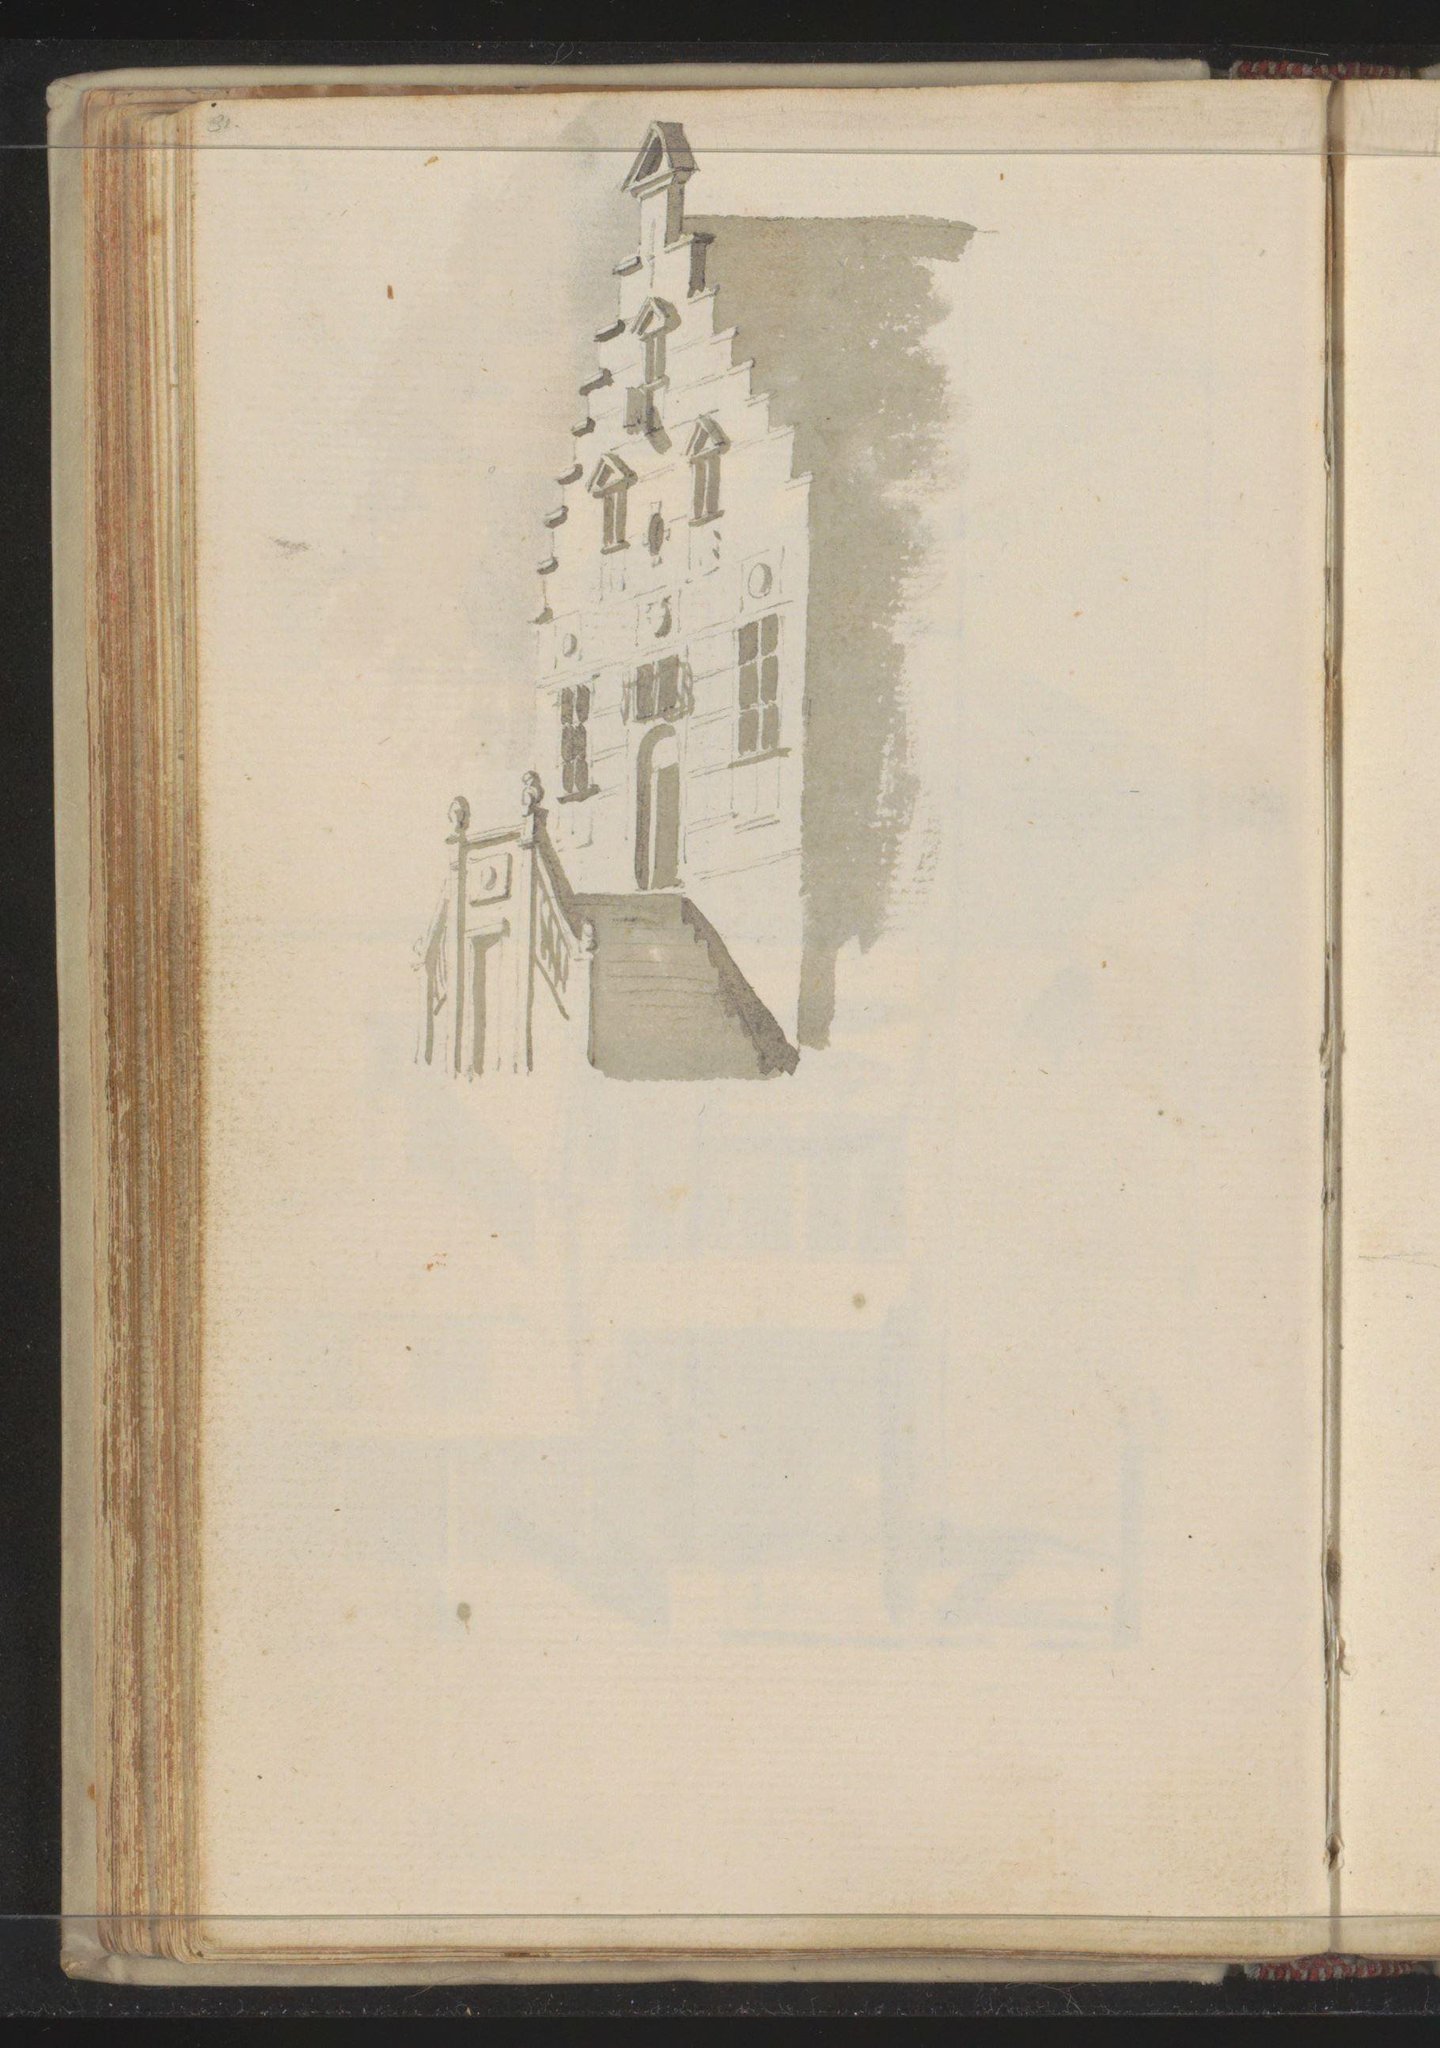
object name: sketchbook leaf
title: Gebouw met een trapgevel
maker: johannes huibert prins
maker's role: draughtsman, painter, print maker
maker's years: 1757-1806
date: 1783-1797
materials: paper, pencil, watercolor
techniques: brush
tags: decorated gable, façade (of house or building)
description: Pagina 81 uit een schetsboek met 175 pagina's.